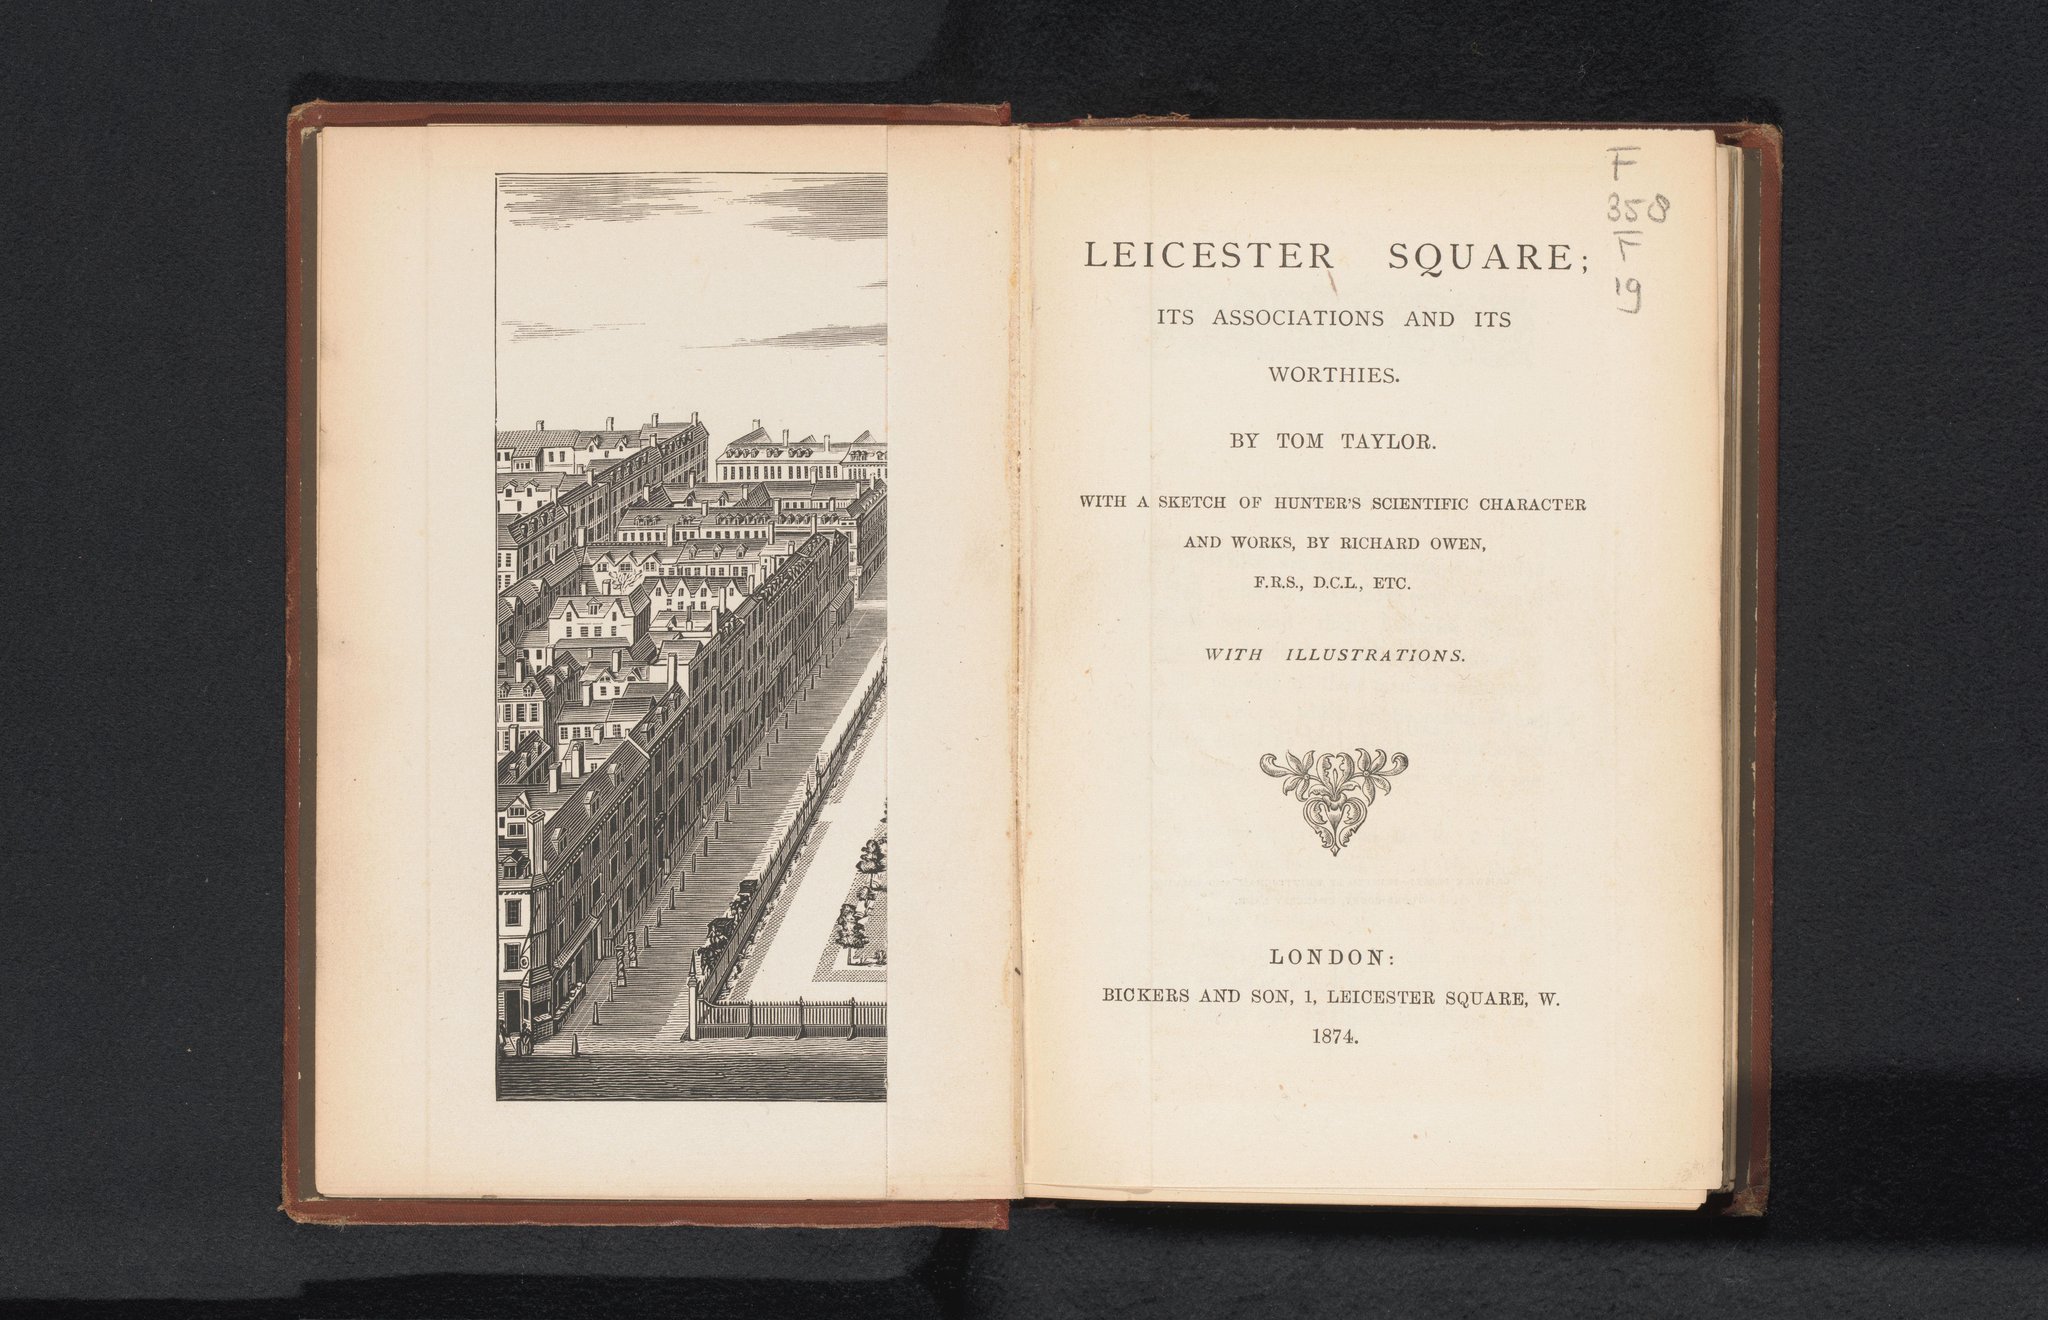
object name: book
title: Leicester Square; its associations and its worthies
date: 1874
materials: cardboard, linen, paper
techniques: etching, lithograph, printing, woodburytype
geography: london